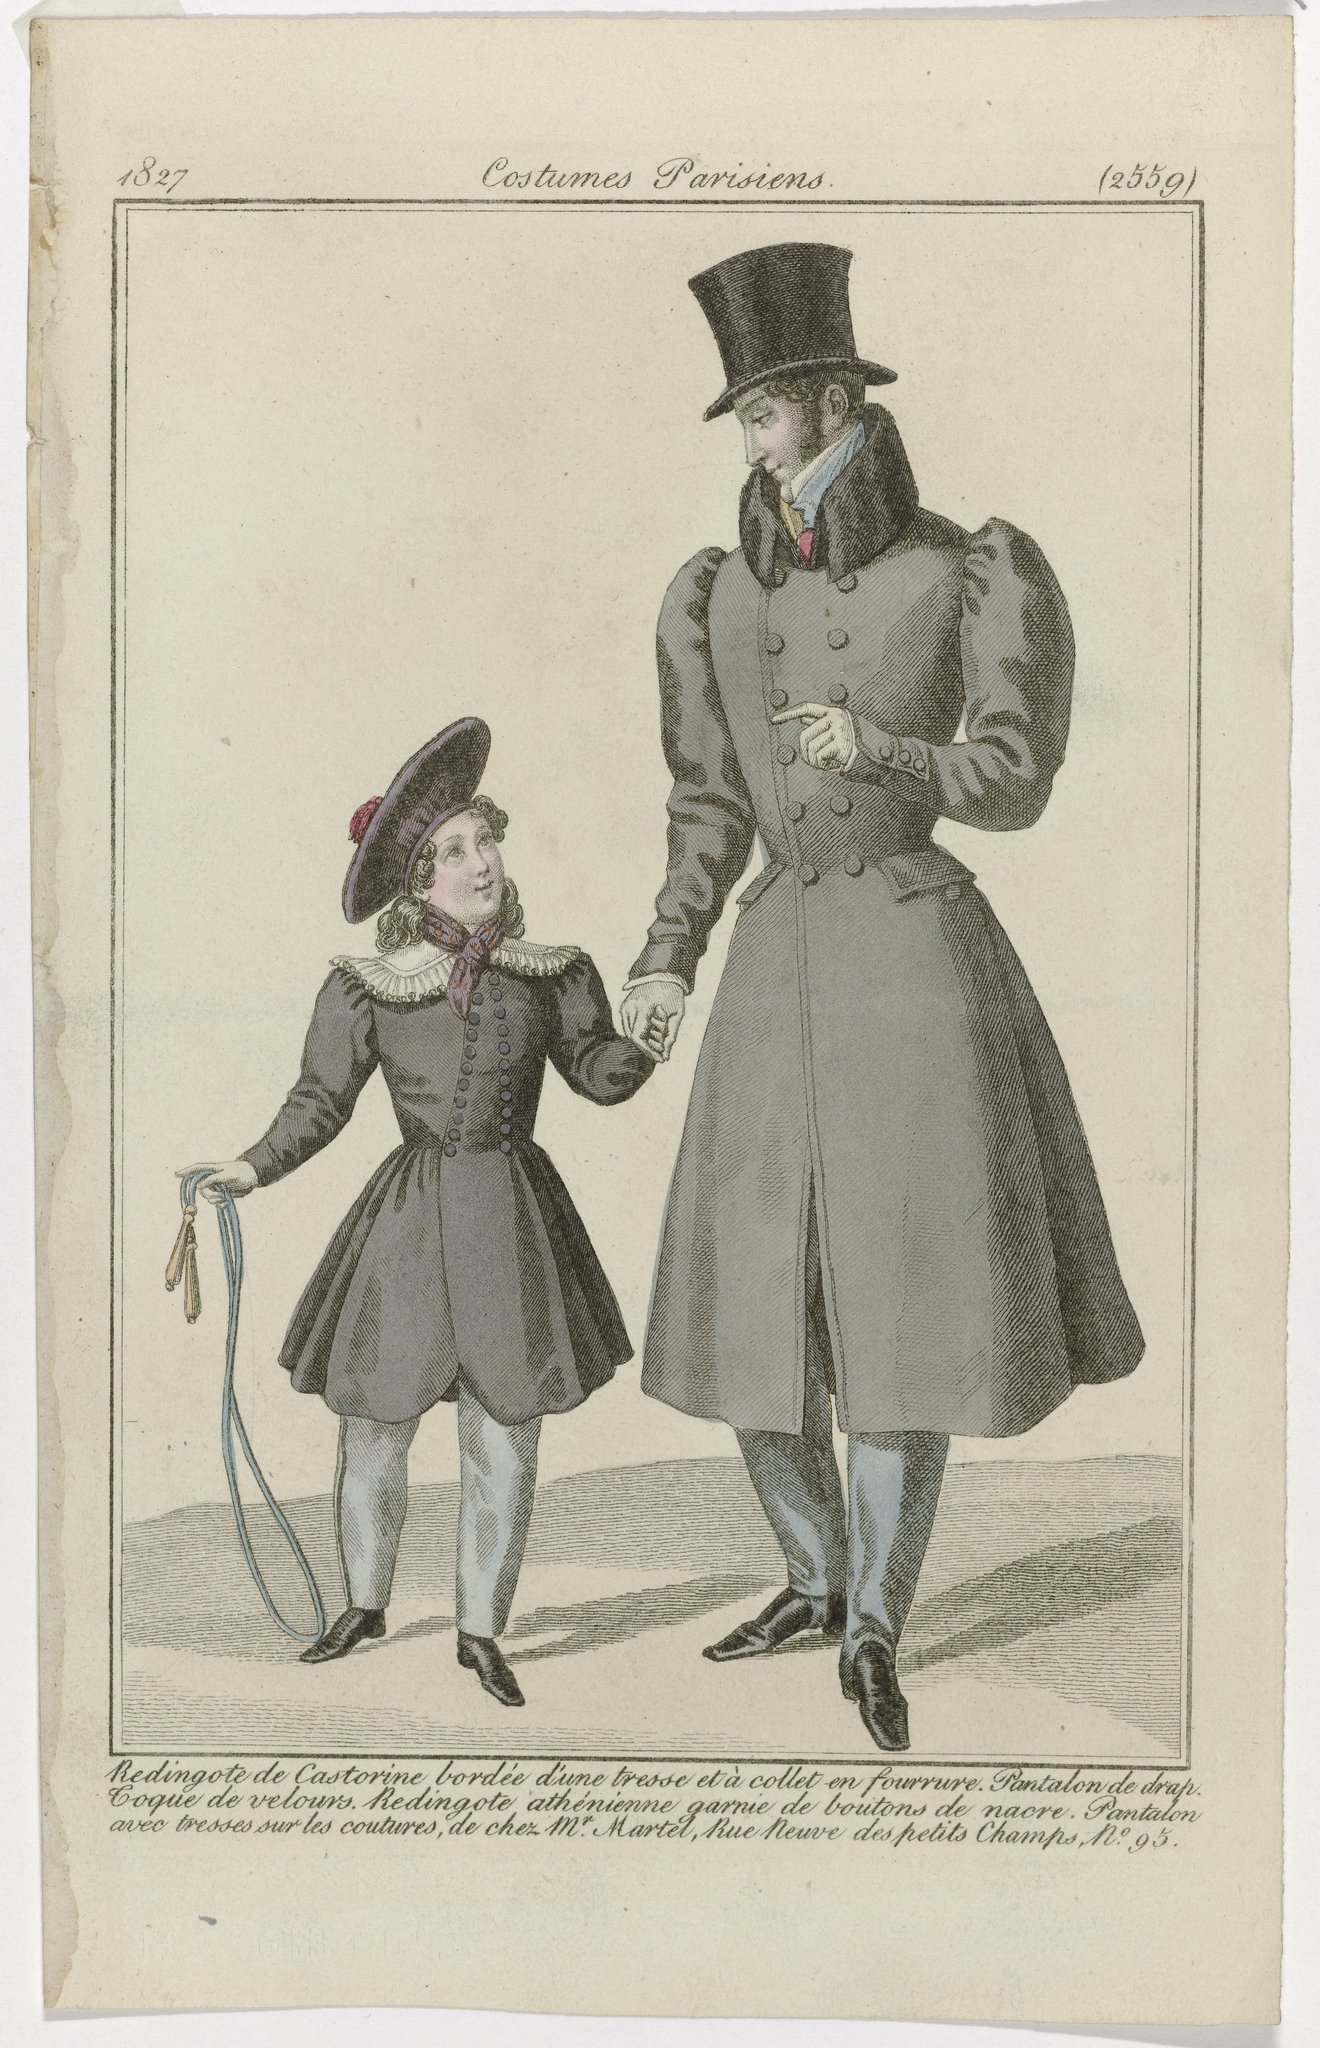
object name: fashion print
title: Journal des Dames et des Modes, Costumes Parisiens, 15 décembre 1827, (2559): Redingote de Castorin (...)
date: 1827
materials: paper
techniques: engraving, hand coloring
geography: paris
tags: trousers, breeches, etc. (pantalon) (+ men's clothes), shoes, sandals (+ boys' clothes), head-gear: toque (+ boys' clothes), trousers, breeches, etc. (pantalon) (+ boys' clothes), coat (+ men's clothes), coat (+ boys' clothes), fashion plates, shoes, sandals (+ men's clothes), neck-gear: collar (+ men's clothes), jumping-rope games, neck-gear: collar (+ fur used for clothes)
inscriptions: caption: ‘Redingote de Castorine bordée d'une tresse et à collet en fourrure. Pantalon de drap. Toque de velours. Redingote athénienne garnie de boutons de nacre. Pantalon avec tresses sur les coutures, de chez Mr. Martel, Rue Neuve des petits Champs, No. 95.’, title: ‘Costumes Parisiens.’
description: Man in een redingote van 'castorine' afgezet met een tres en een bontkraag. Spanbroek van laken. Accessoires: hoge hoed, schoenen met vierkante neuzen. Aan de hand een jongen met op het hoofd een 'toque' van fluweel. Hij draagt een 'redingote athénienne' met knopen van parelmoer. Lange broek met tressen op de naden van Mr Martel. Springtouw in de hand. Prent uit het modetijdschrift Journal des Dames et des Modes (1797-1839).